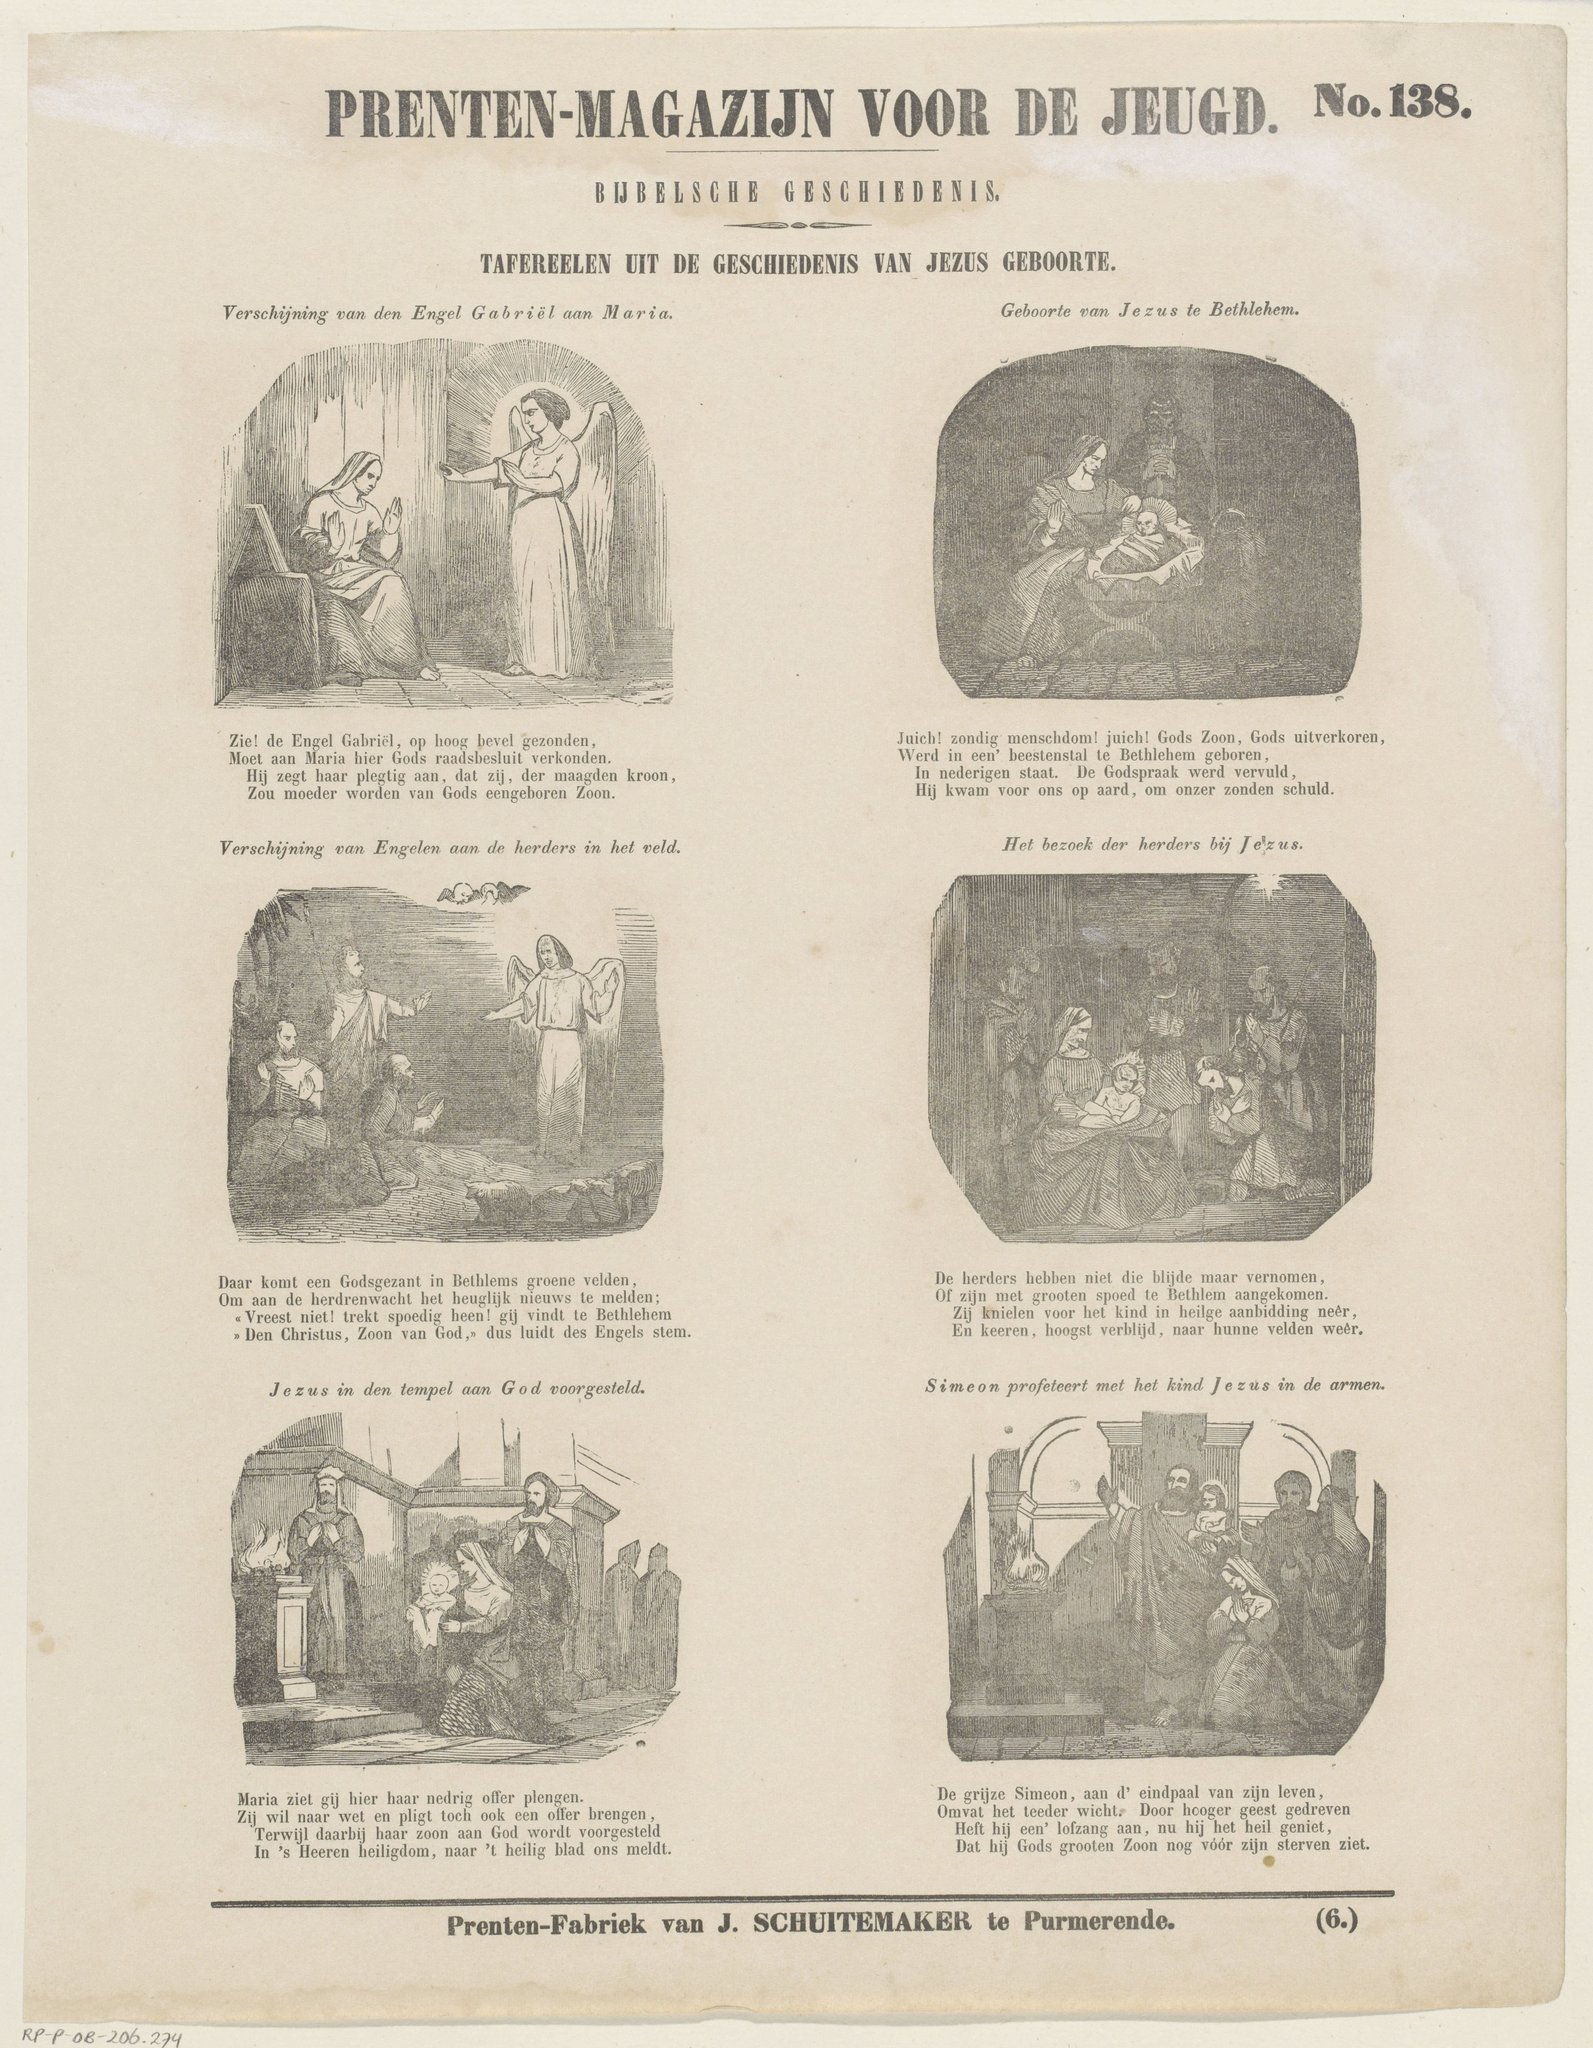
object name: popular print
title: Bijbelsche geschiedenis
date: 1850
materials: paper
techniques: letterpress printing, engraving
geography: purmerend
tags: adoration of the christ-child by the shepherds; mary and joseph present, story of the birth of christ (luke 2:1-20), new testament, birth and youth of christ, series of scenes from the life of christ, mary, joseph and the new-born christ (nativity)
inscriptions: collector's mark: Lugt 2760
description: Na voltooiing van de acht jaargangen van de reeks 'Prenten-magazijn voor de jeugd' in 1850 heeft Jan Schuitemaker al deze prenten heruitgegeven en omgenummerd als nr. 1 t/m 192. De oorspronkelijke jaargang wordt telkens nog vermeld rechtsonder op de prent. Binnen de jaargangen zijn prenten van hetzelfde thema in clusters van vier achter elkaar gezet.